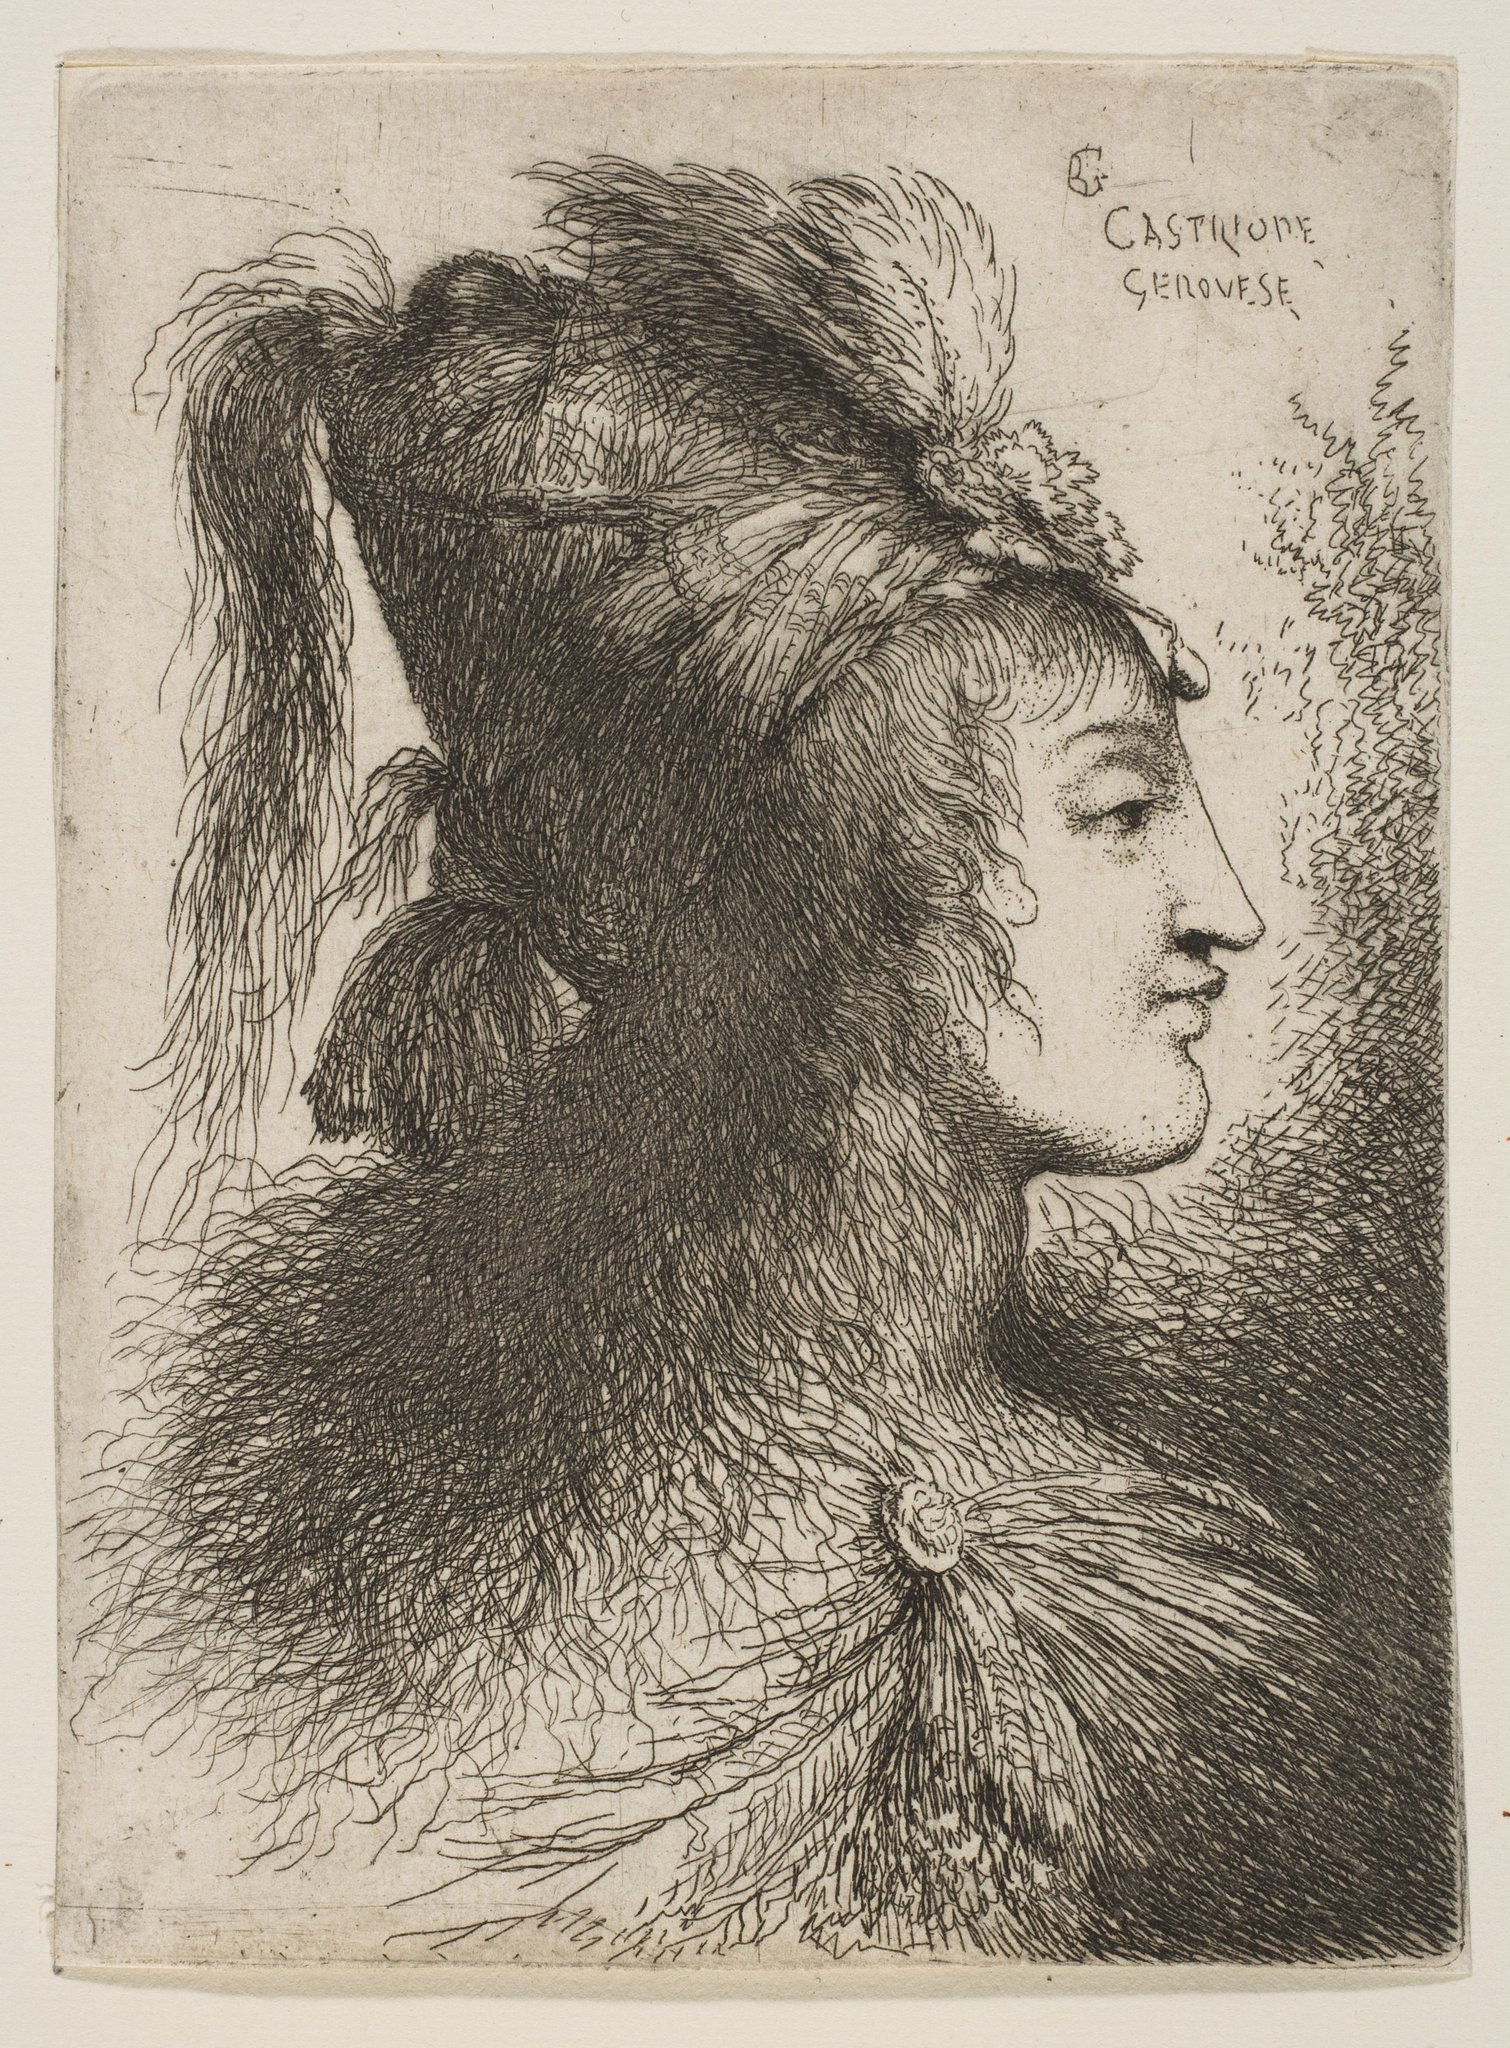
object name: print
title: Young man wearing a plumed turban, facing right, from "Small Heads in Oriental Headdress"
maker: giovanni benedetto castiglione (il grechetto)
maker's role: artist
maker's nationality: italian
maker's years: 1609-1664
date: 1645-1650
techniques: etching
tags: men,profiles